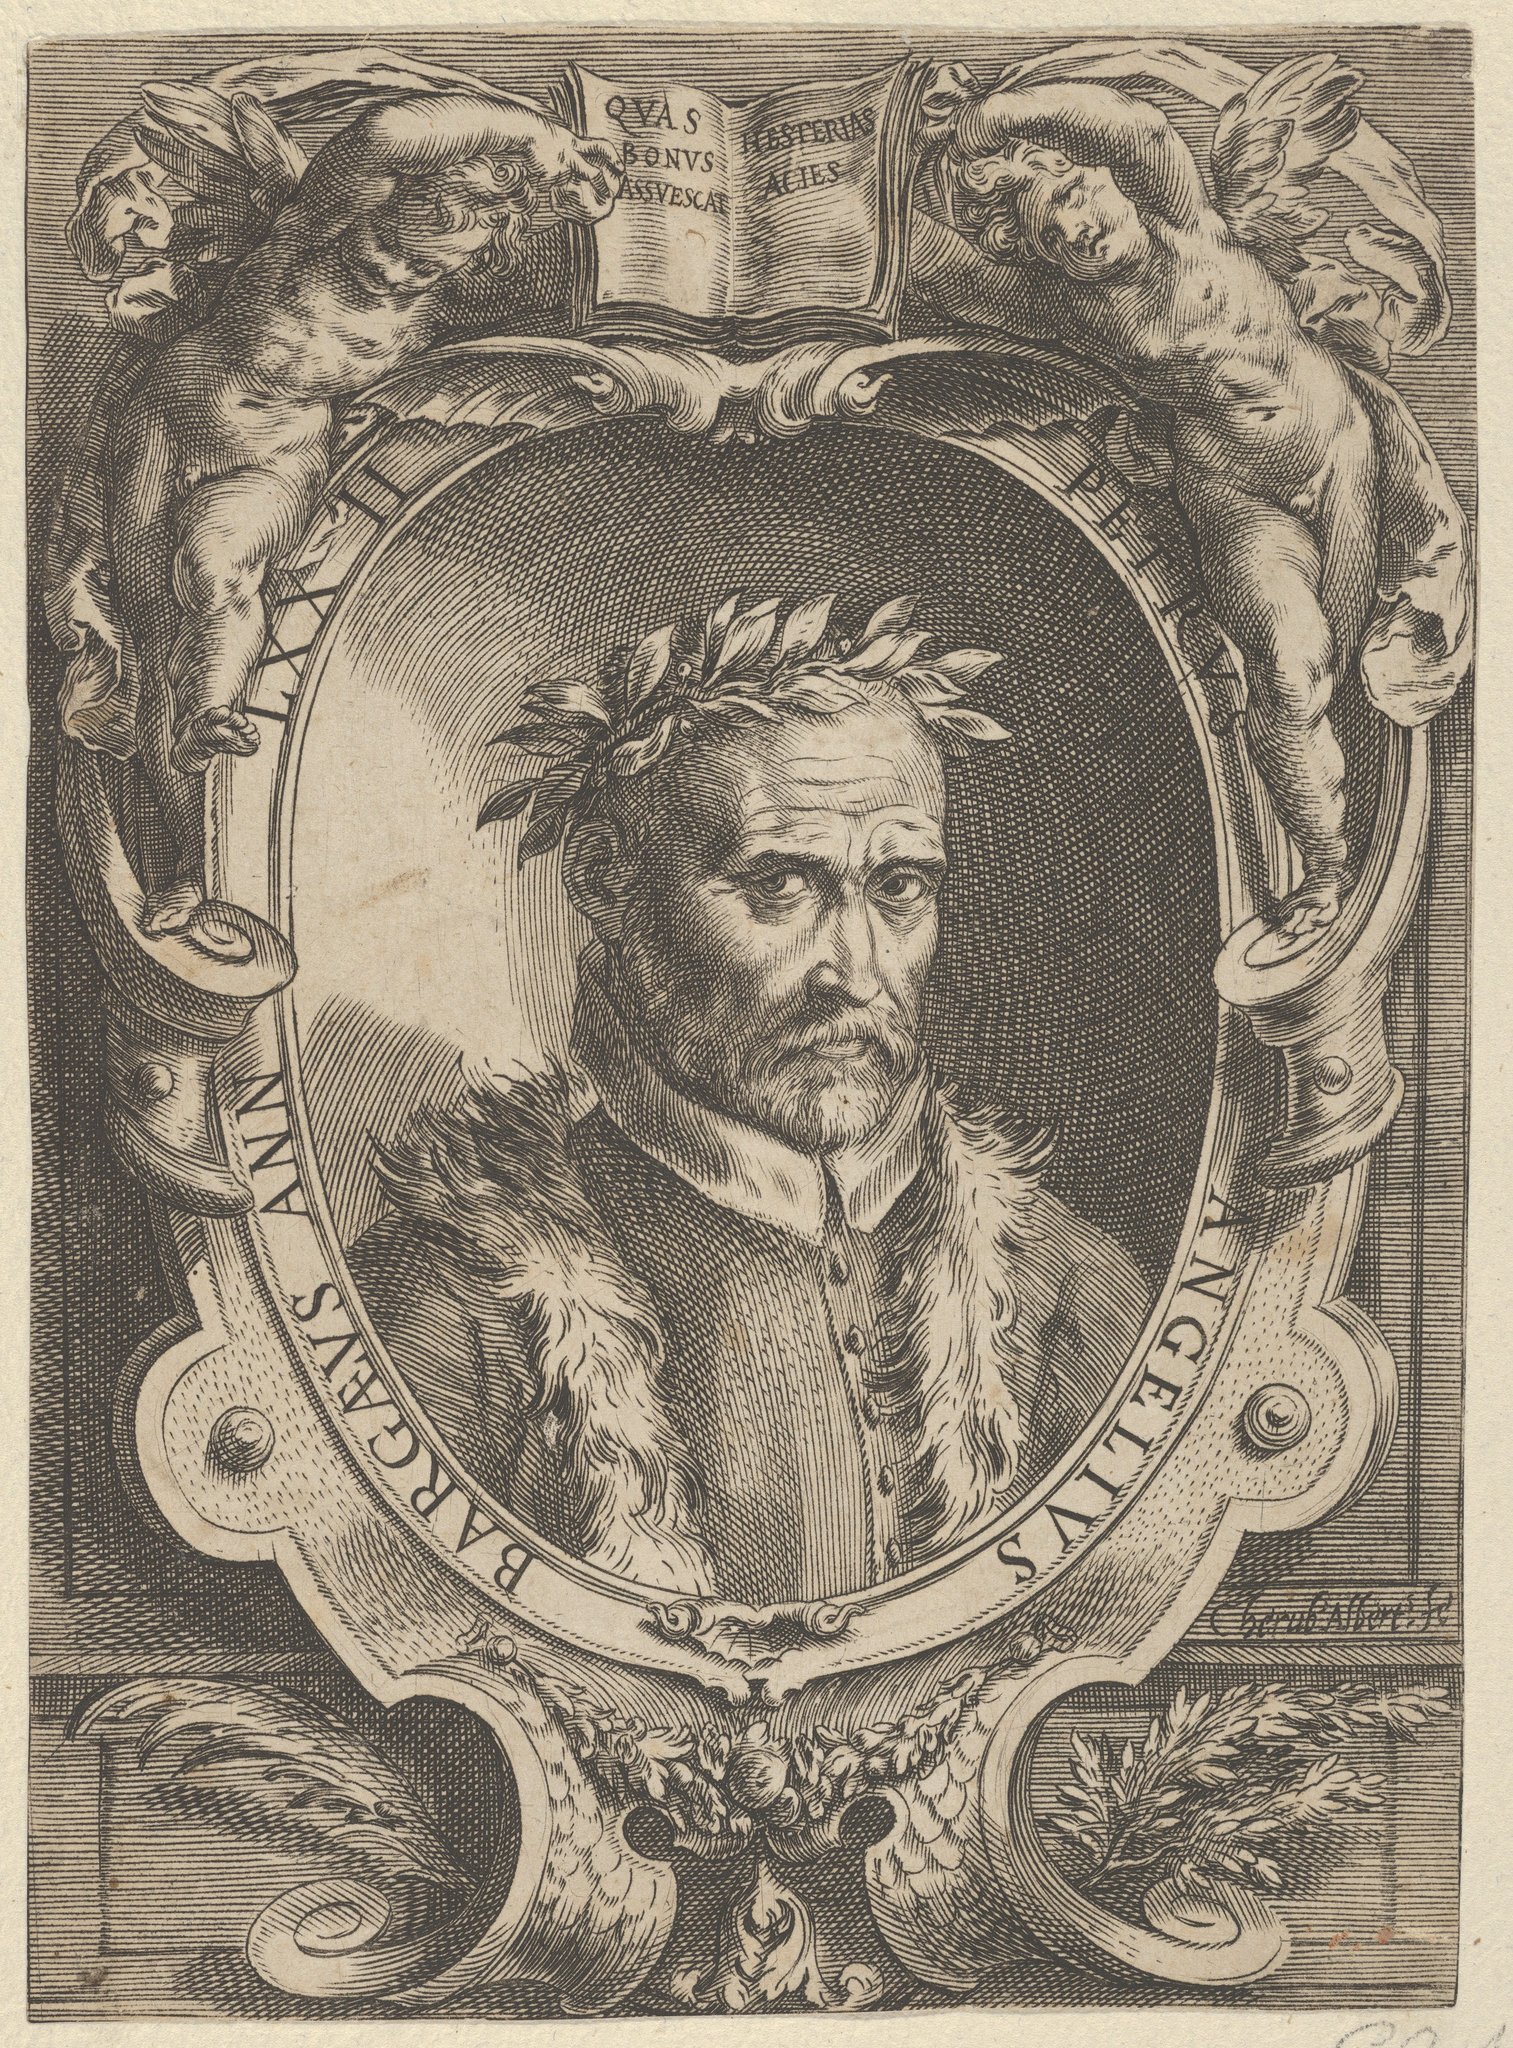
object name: print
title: Portrait of Pietro Angela da Barga, bust-length and in a decorative border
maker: cherubino alberti (zaccaria mattia)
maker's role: artist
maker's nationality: italian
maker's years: 1553-1615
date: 1570-1615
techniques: engraving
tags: men,portraits